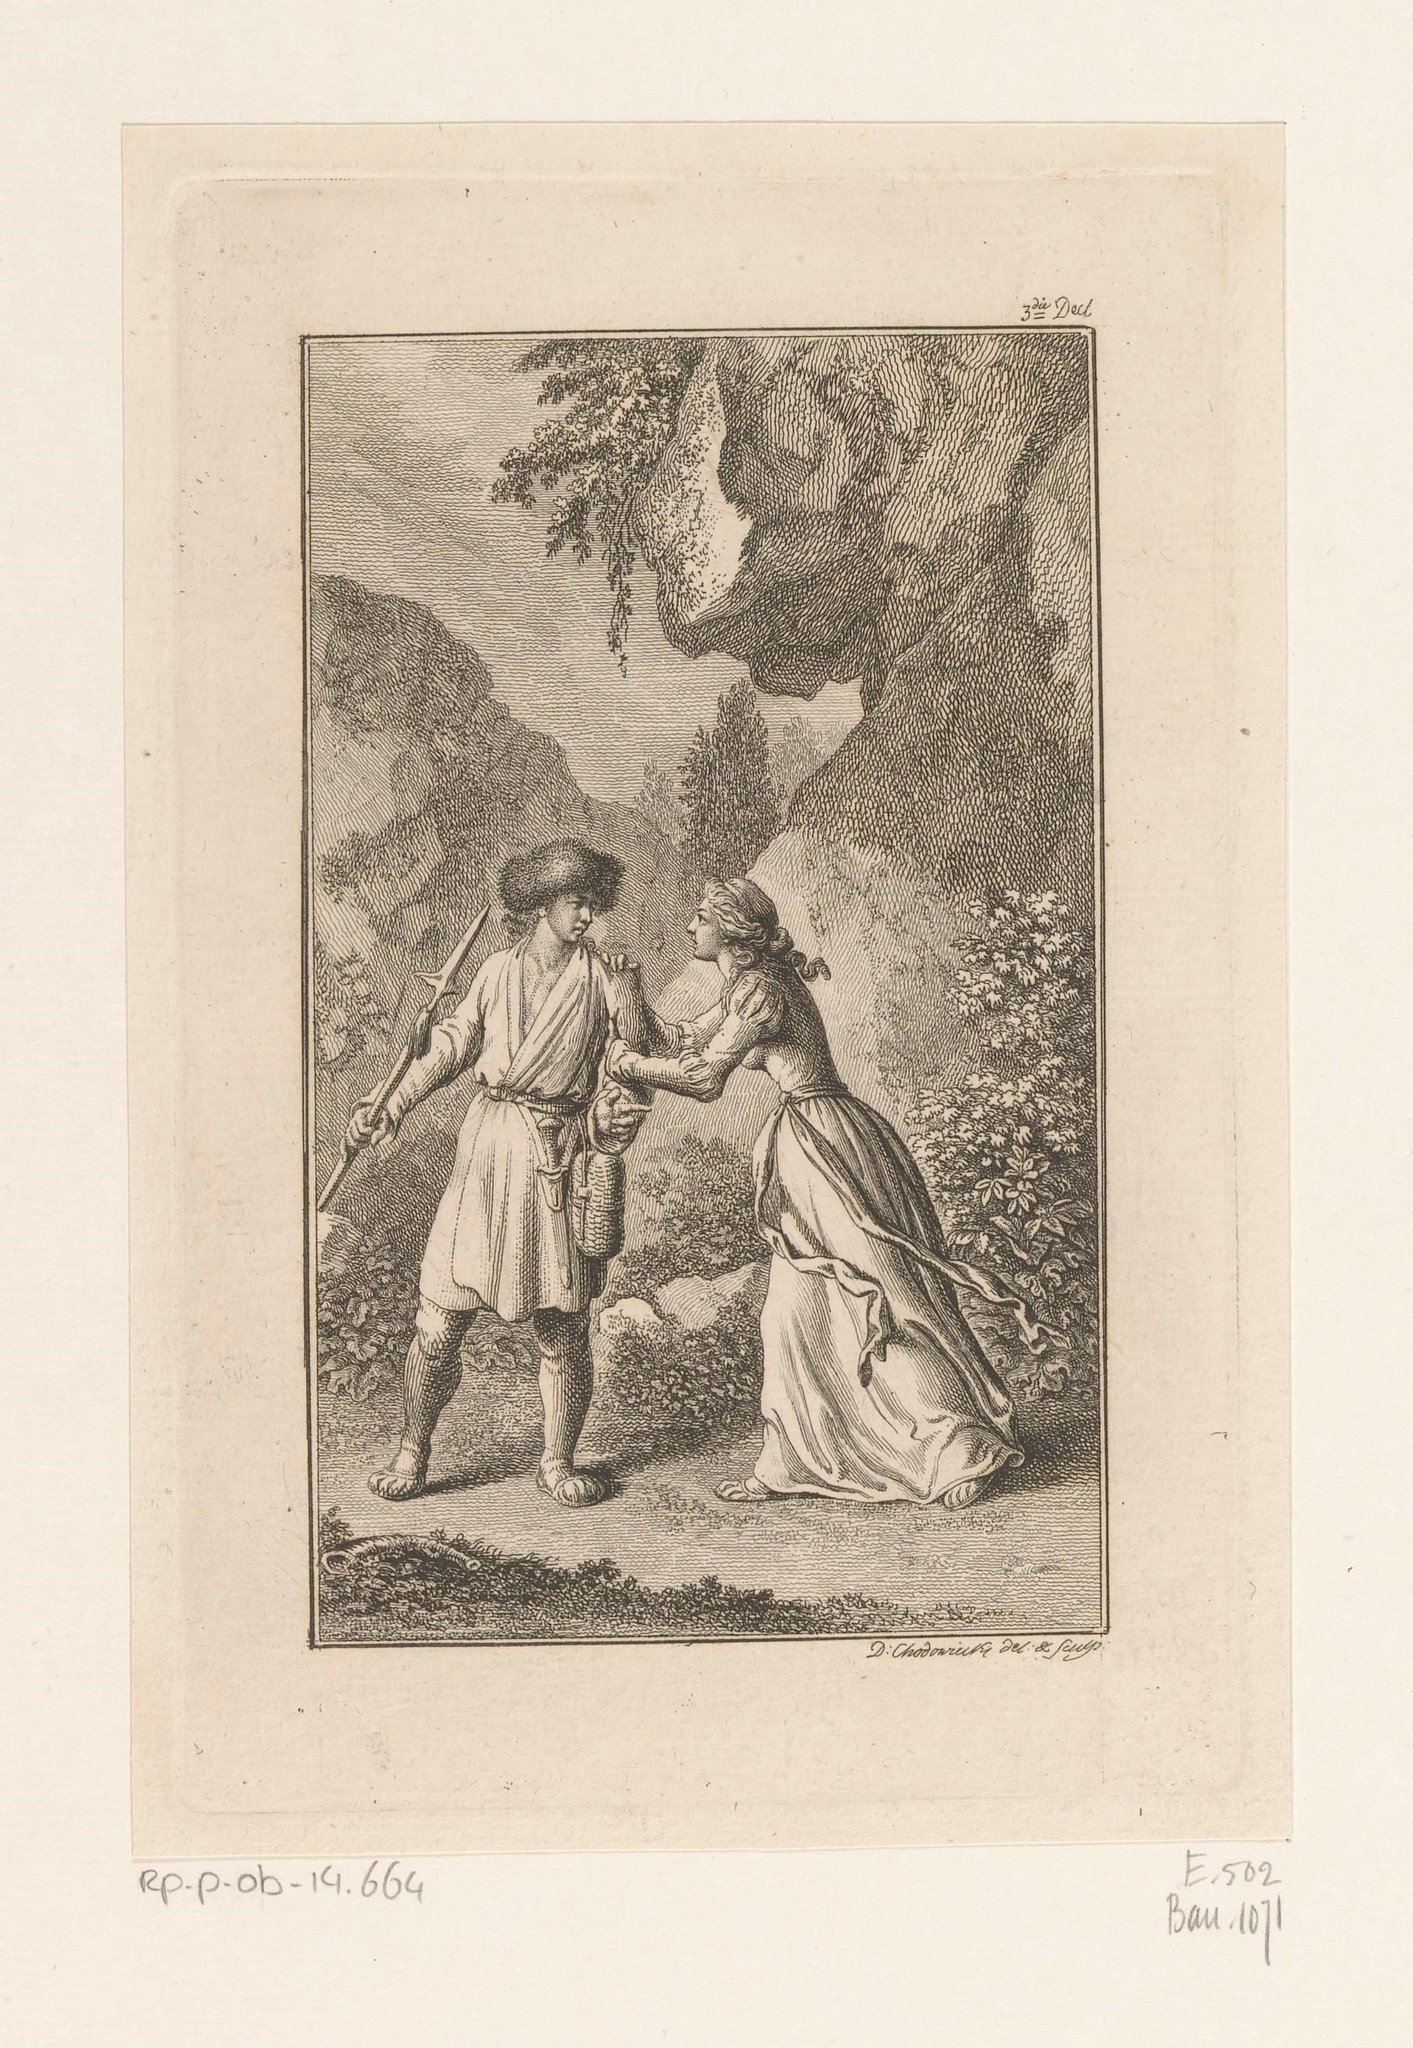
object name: print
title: Nanna smeekt Hoder om niet tegen Balder te strijden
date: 1784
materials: paper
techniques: etching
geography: berlin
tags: germanic and scandinavian religions, landscapes, representations ~ gods, demi-gods, heroes etc. (germanic and scandinavian religions), gripping someone by the hand or the wrist; clasped hands - aa - both arms or hands, casting weapons: spear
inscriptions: collector's mark: Lugt 2228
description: Prent uit: Ewald, Johannes. Balder's Tod. Ein traurspiel mit Gesang (...). 2de druk. Kopenhagen: Christ. Gottlob Proft, 1785.